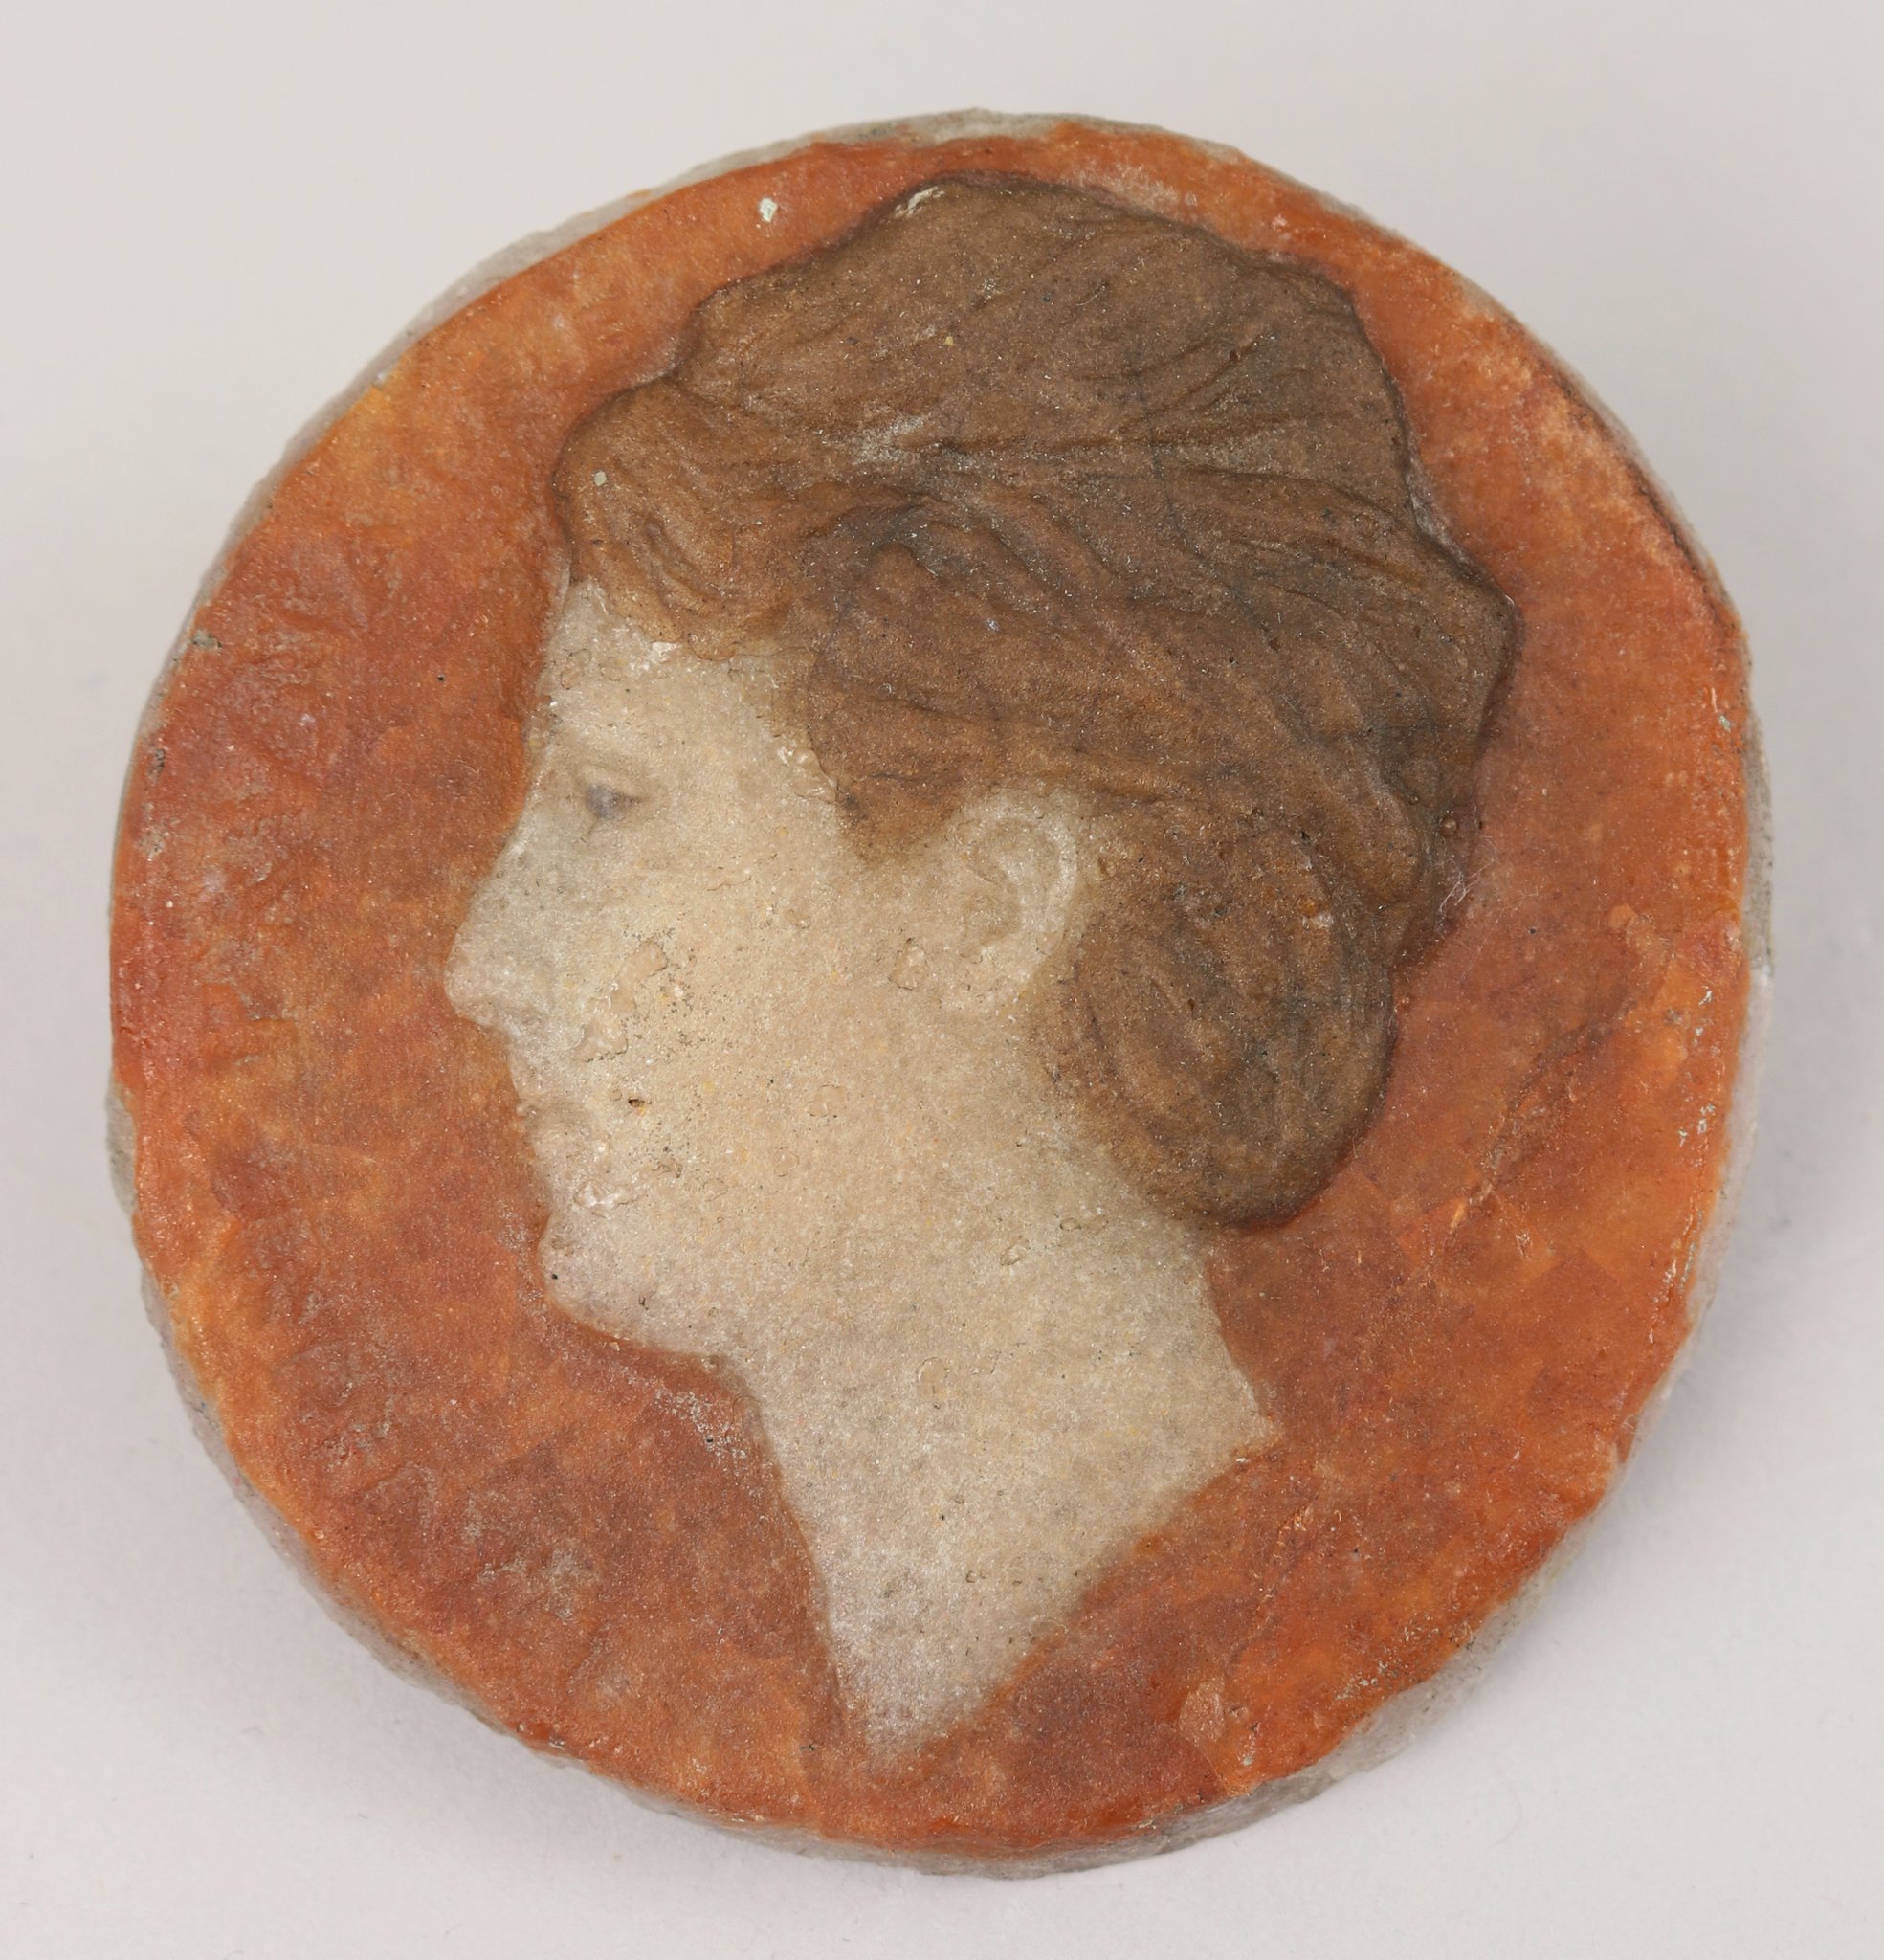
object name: medal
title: Fanny Prunaire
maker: césar-isidore-henry cros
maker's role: maker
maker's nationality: french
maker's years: 1840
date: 1880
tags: profiles,women